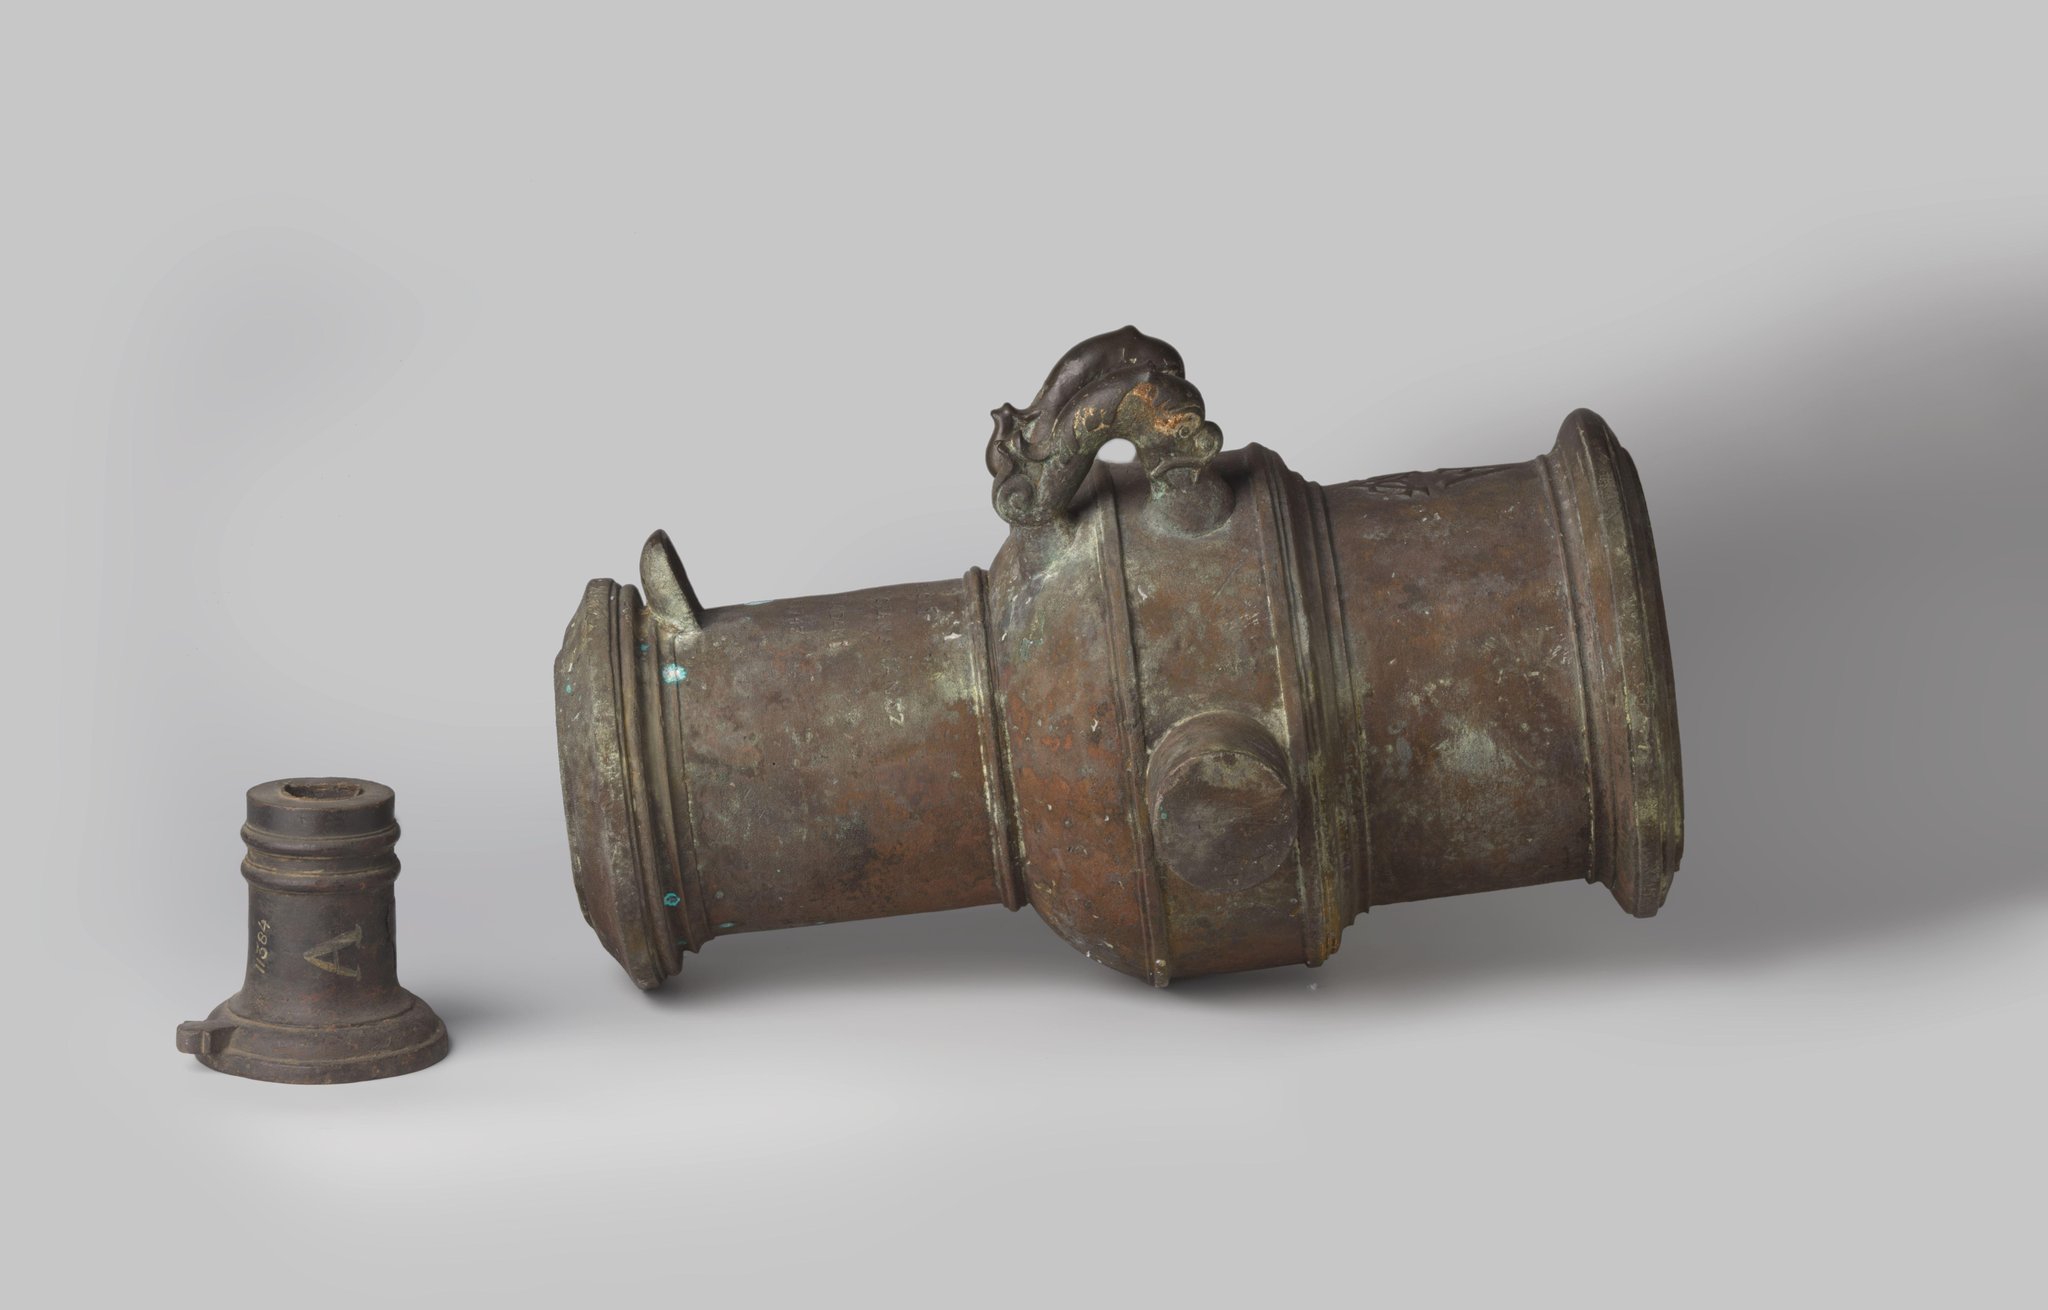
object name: mortar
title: Bronzen mortier, 64 ponder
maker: cipriaen jansz. crans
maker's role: brazier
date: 1743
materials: bronze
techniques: casting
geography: amsterdam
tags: annet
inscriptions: inscription: ‘VOC / A’, signature and date: ‘ME FECIT CIPRIANUS CRANS IANSZ AMSTELODAMI ANNO 1743’